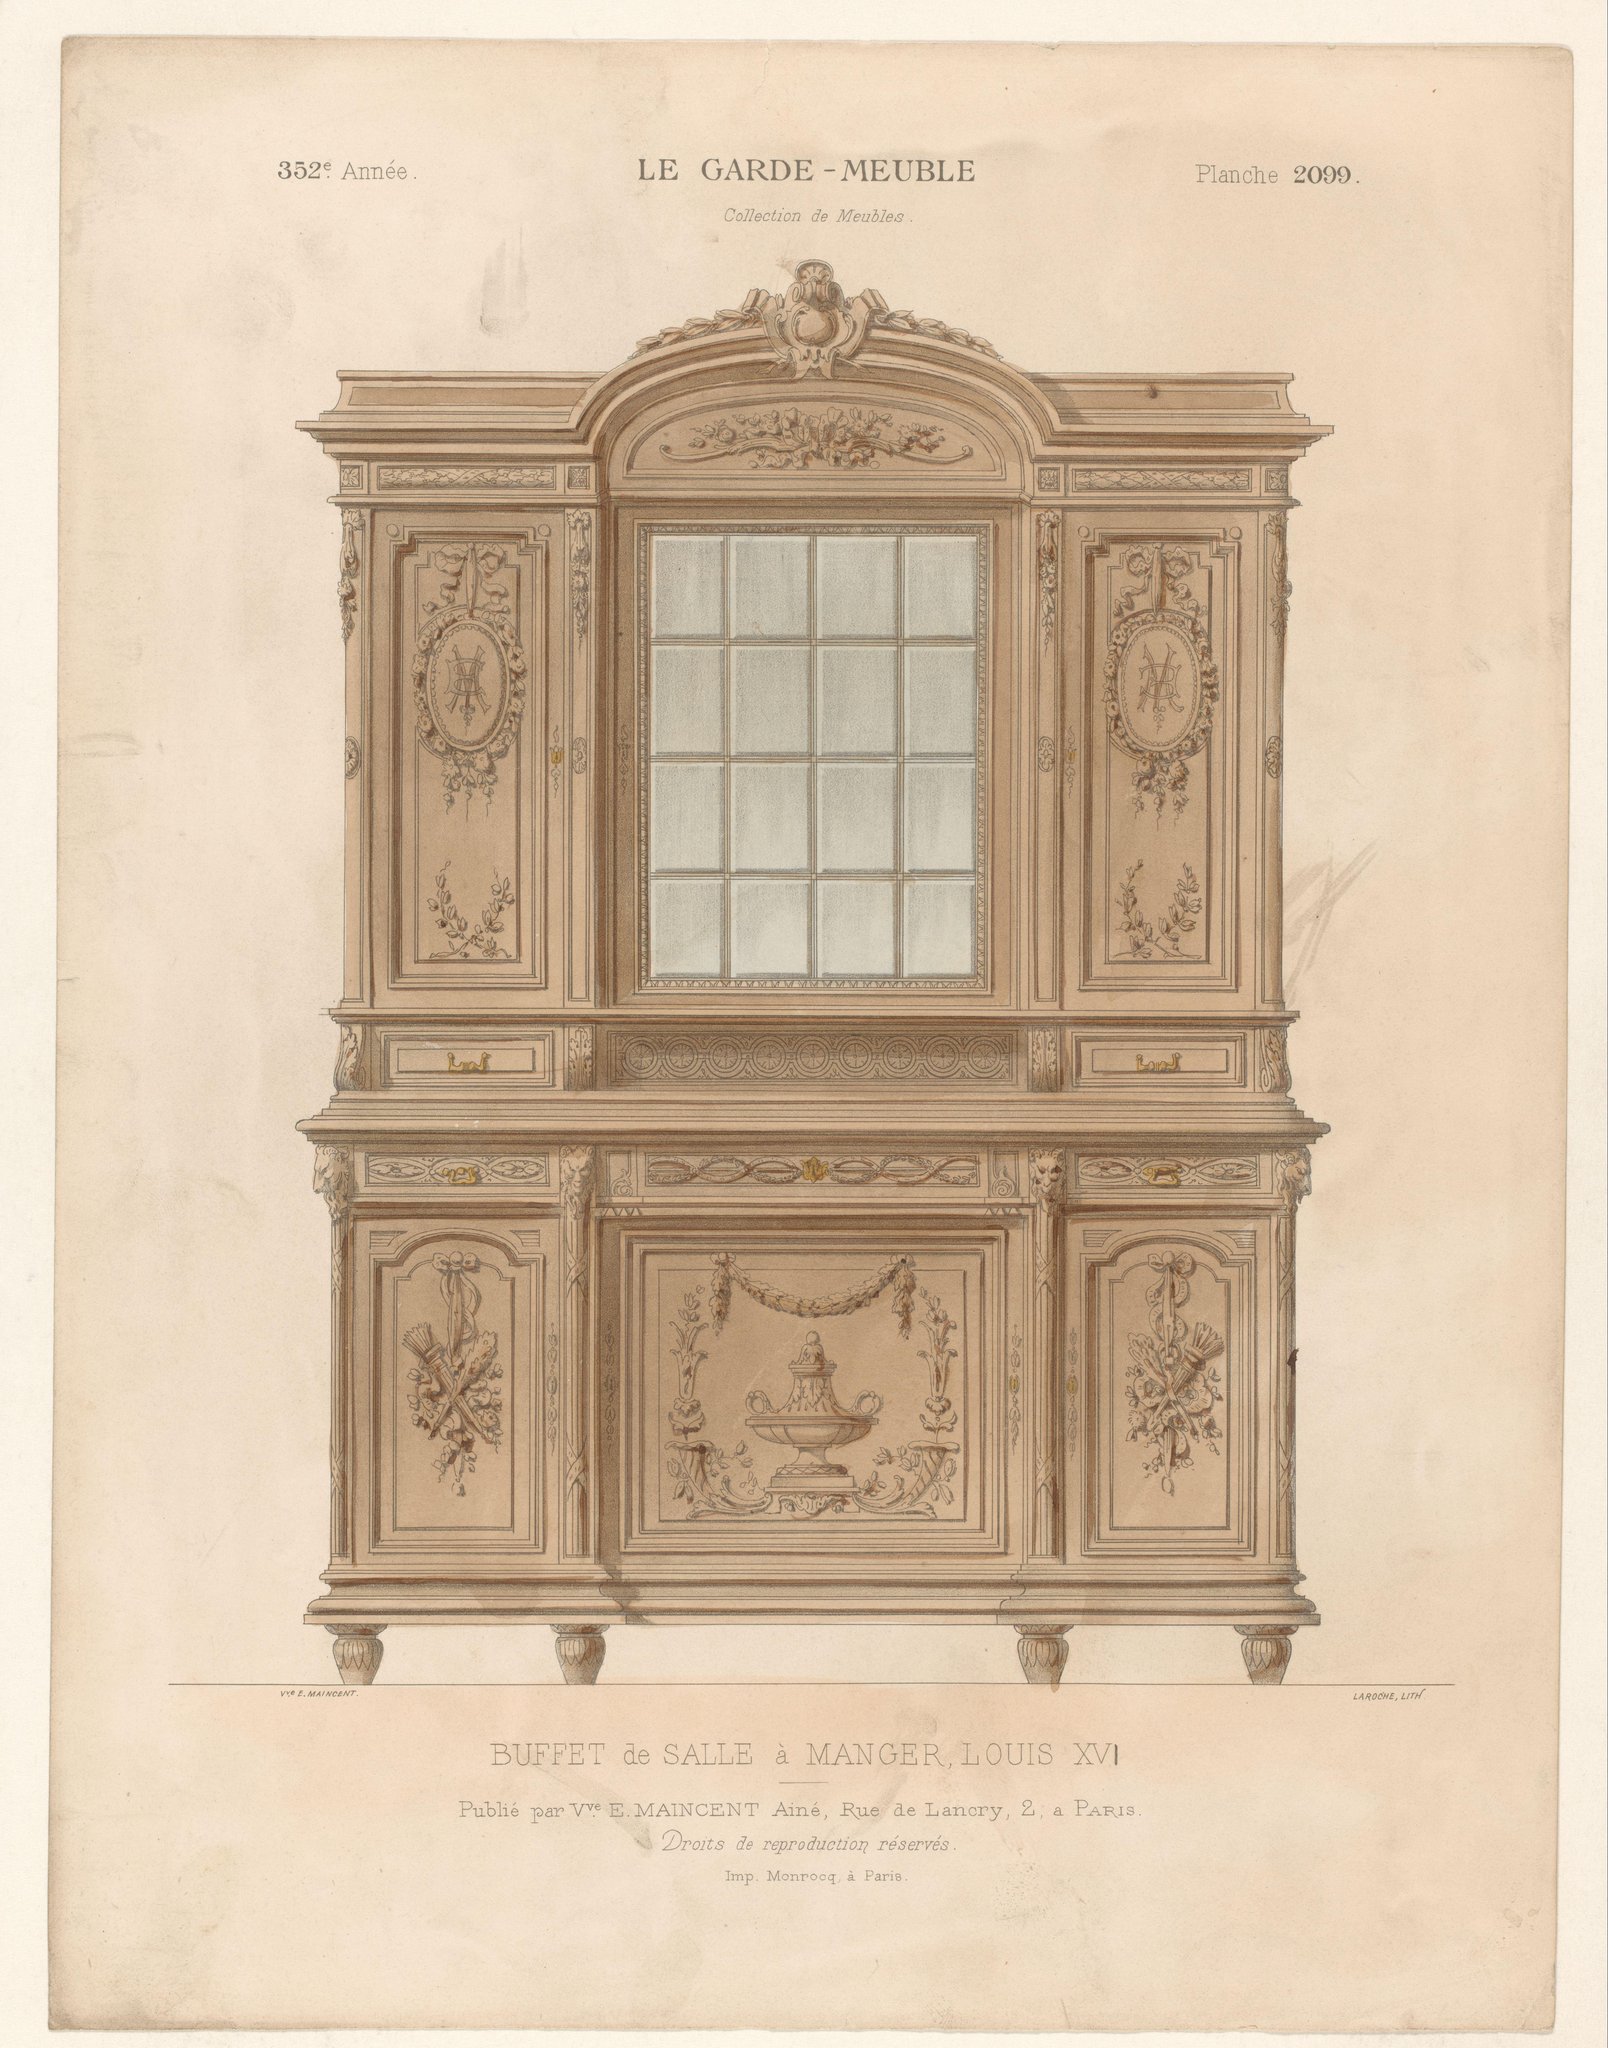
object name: print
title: Le garde-meuble / Collection de Meubles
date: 1895-1935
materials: paper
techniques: hand coloring, lithograph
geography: paris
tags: furniture for storage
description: Ieder Livraison in de serie Le Garde-Meuble bevat negen platen: drie 'sièges' (zitmeubels), drie 'meubles' (diverse meubels zoals tafels en kasten) en drie 'tentures' (gordijnen en draperieën).